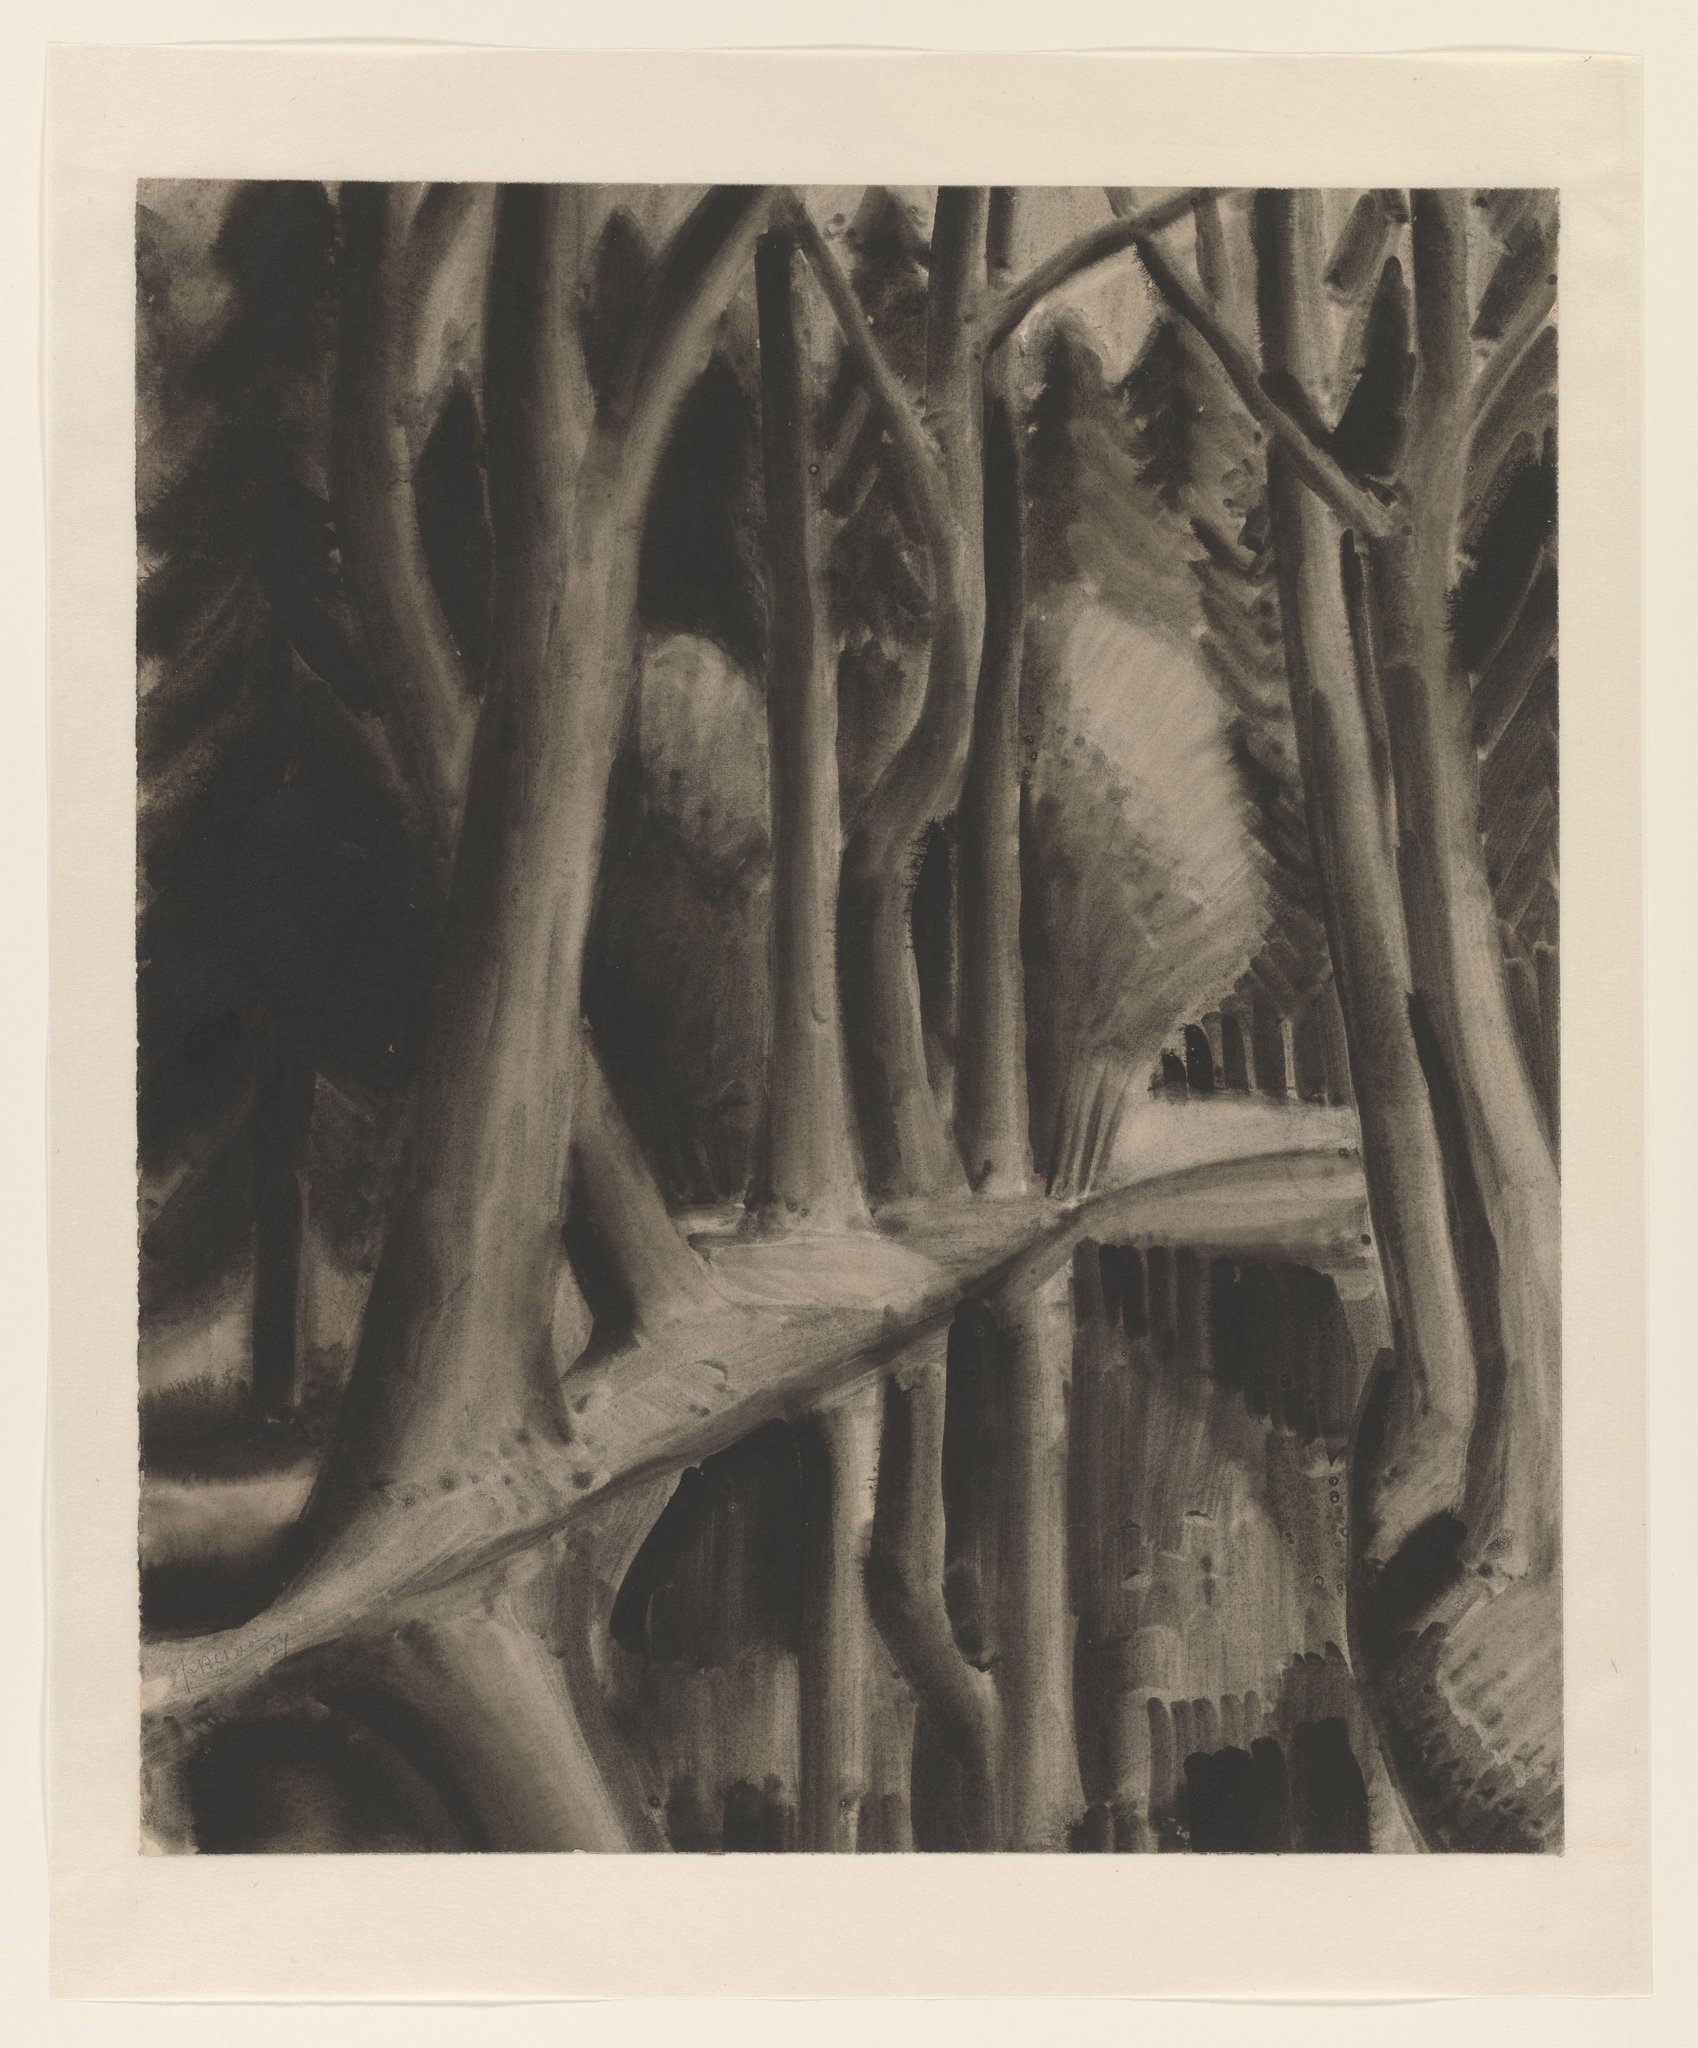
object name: drawing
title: Bosvijver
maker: jo bezaan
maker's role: draughtsman, print maker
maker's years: 1894-1952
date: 1927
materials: paper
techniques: brush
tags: forest, wood